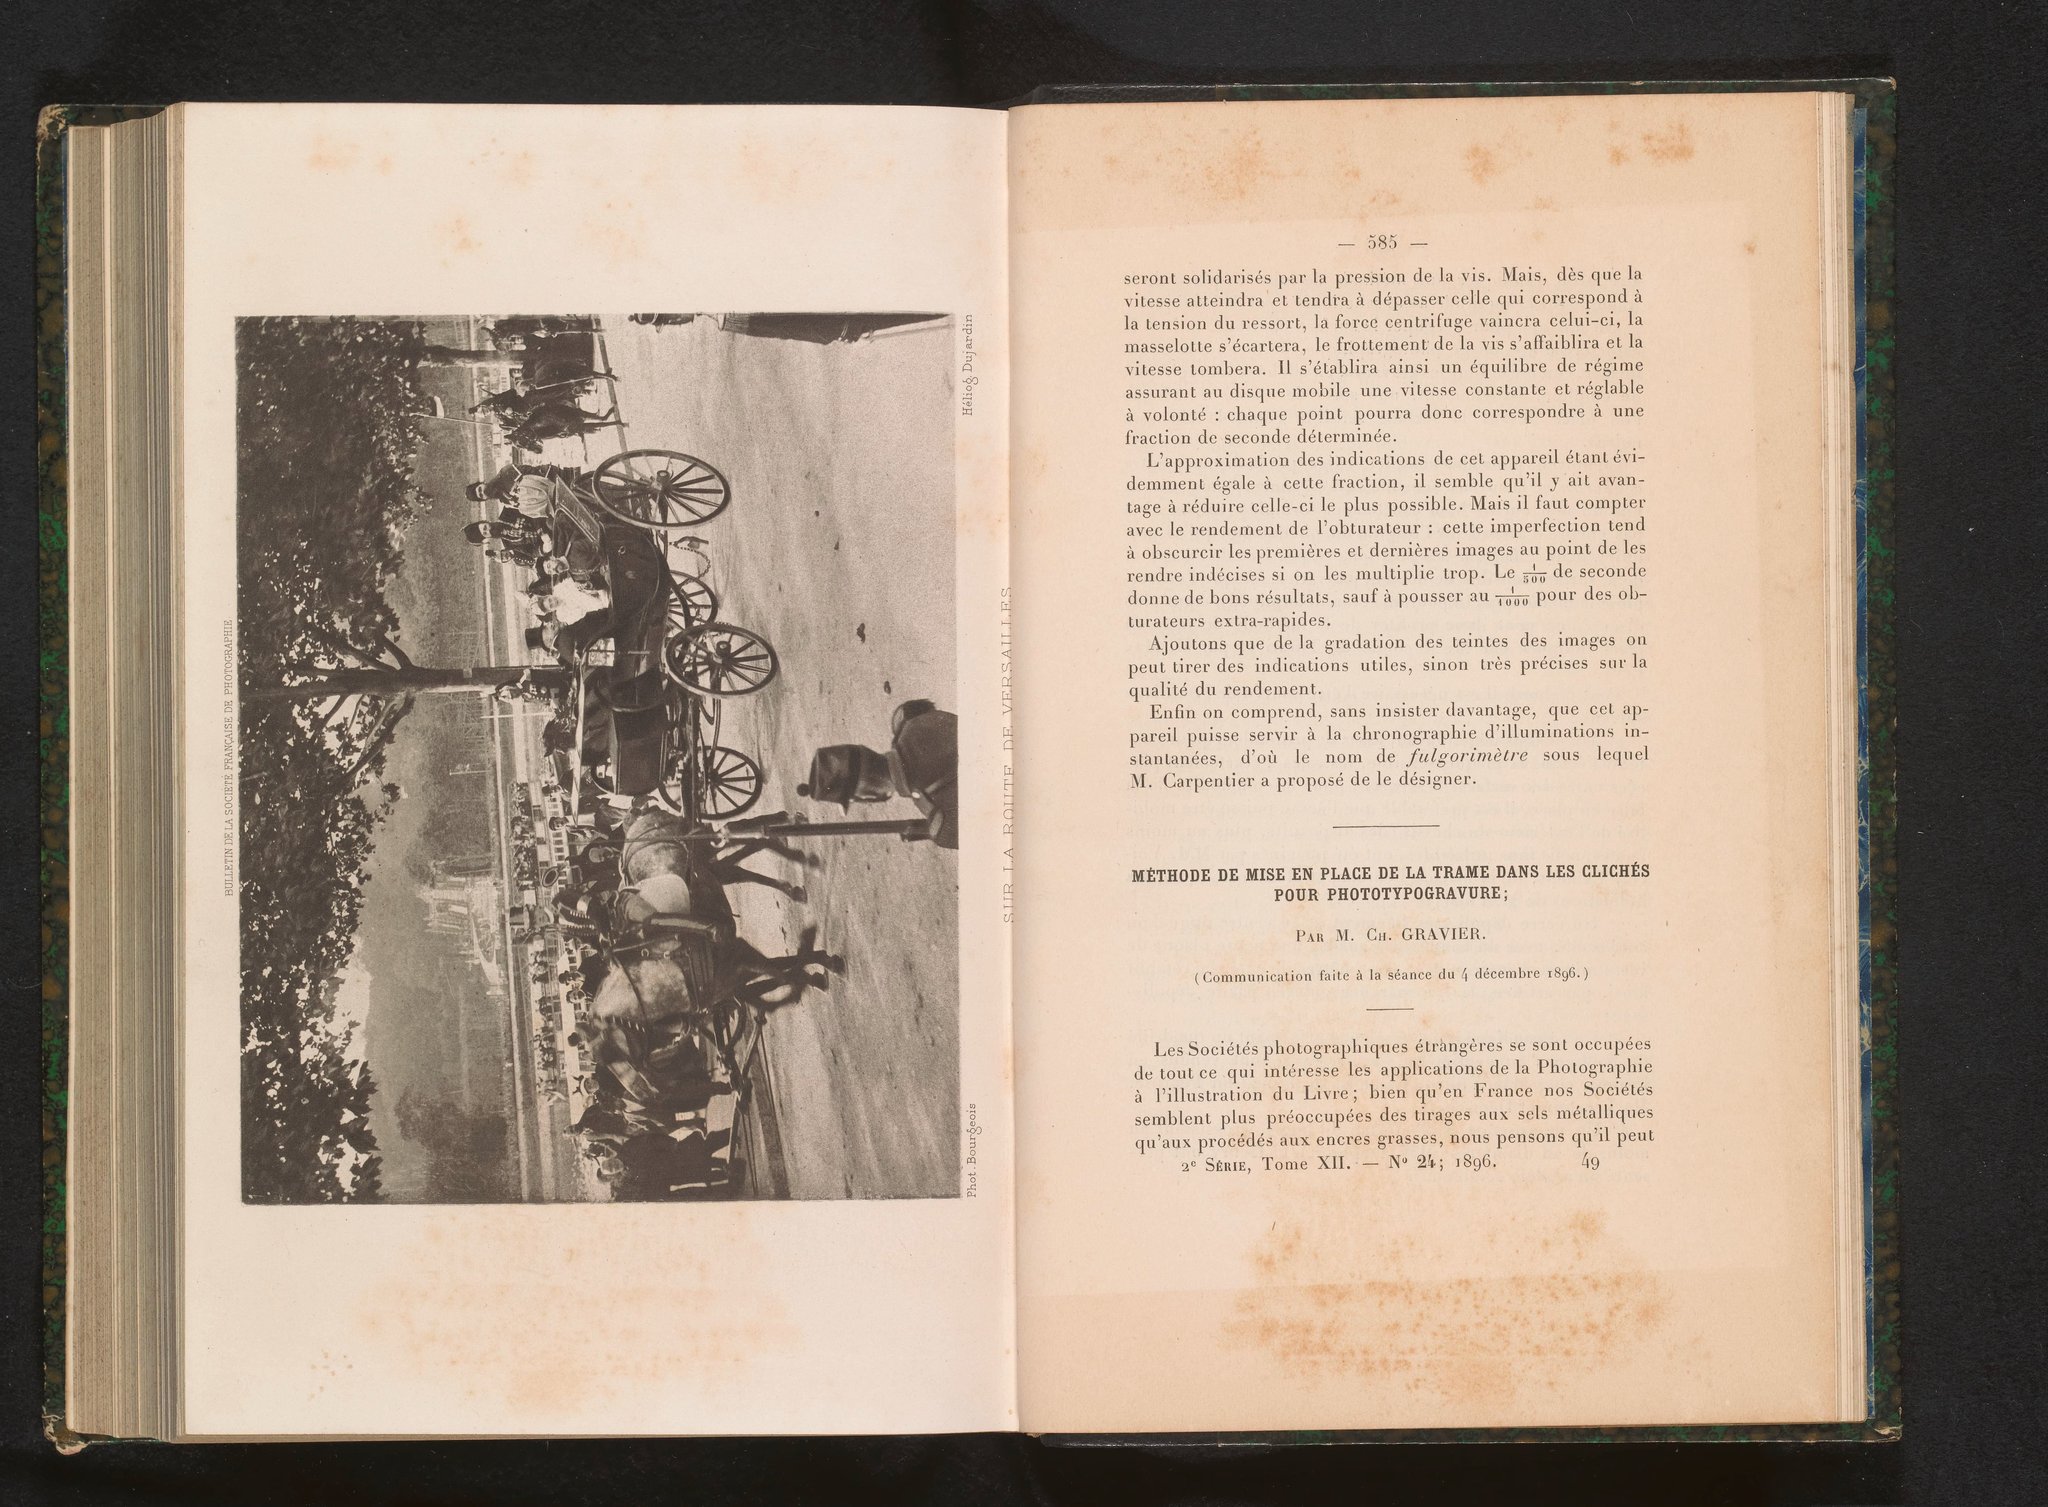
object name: photomechanical print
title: Koets met tsaar Nicolaas II van Rusland en tsarina Alexandra Fjodorovna nabij Versailles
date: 1896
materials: paper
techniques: photoaquatint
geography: france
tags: ruler, sovereign - bb - female ruler, ruler, sovereign, passenger carriage